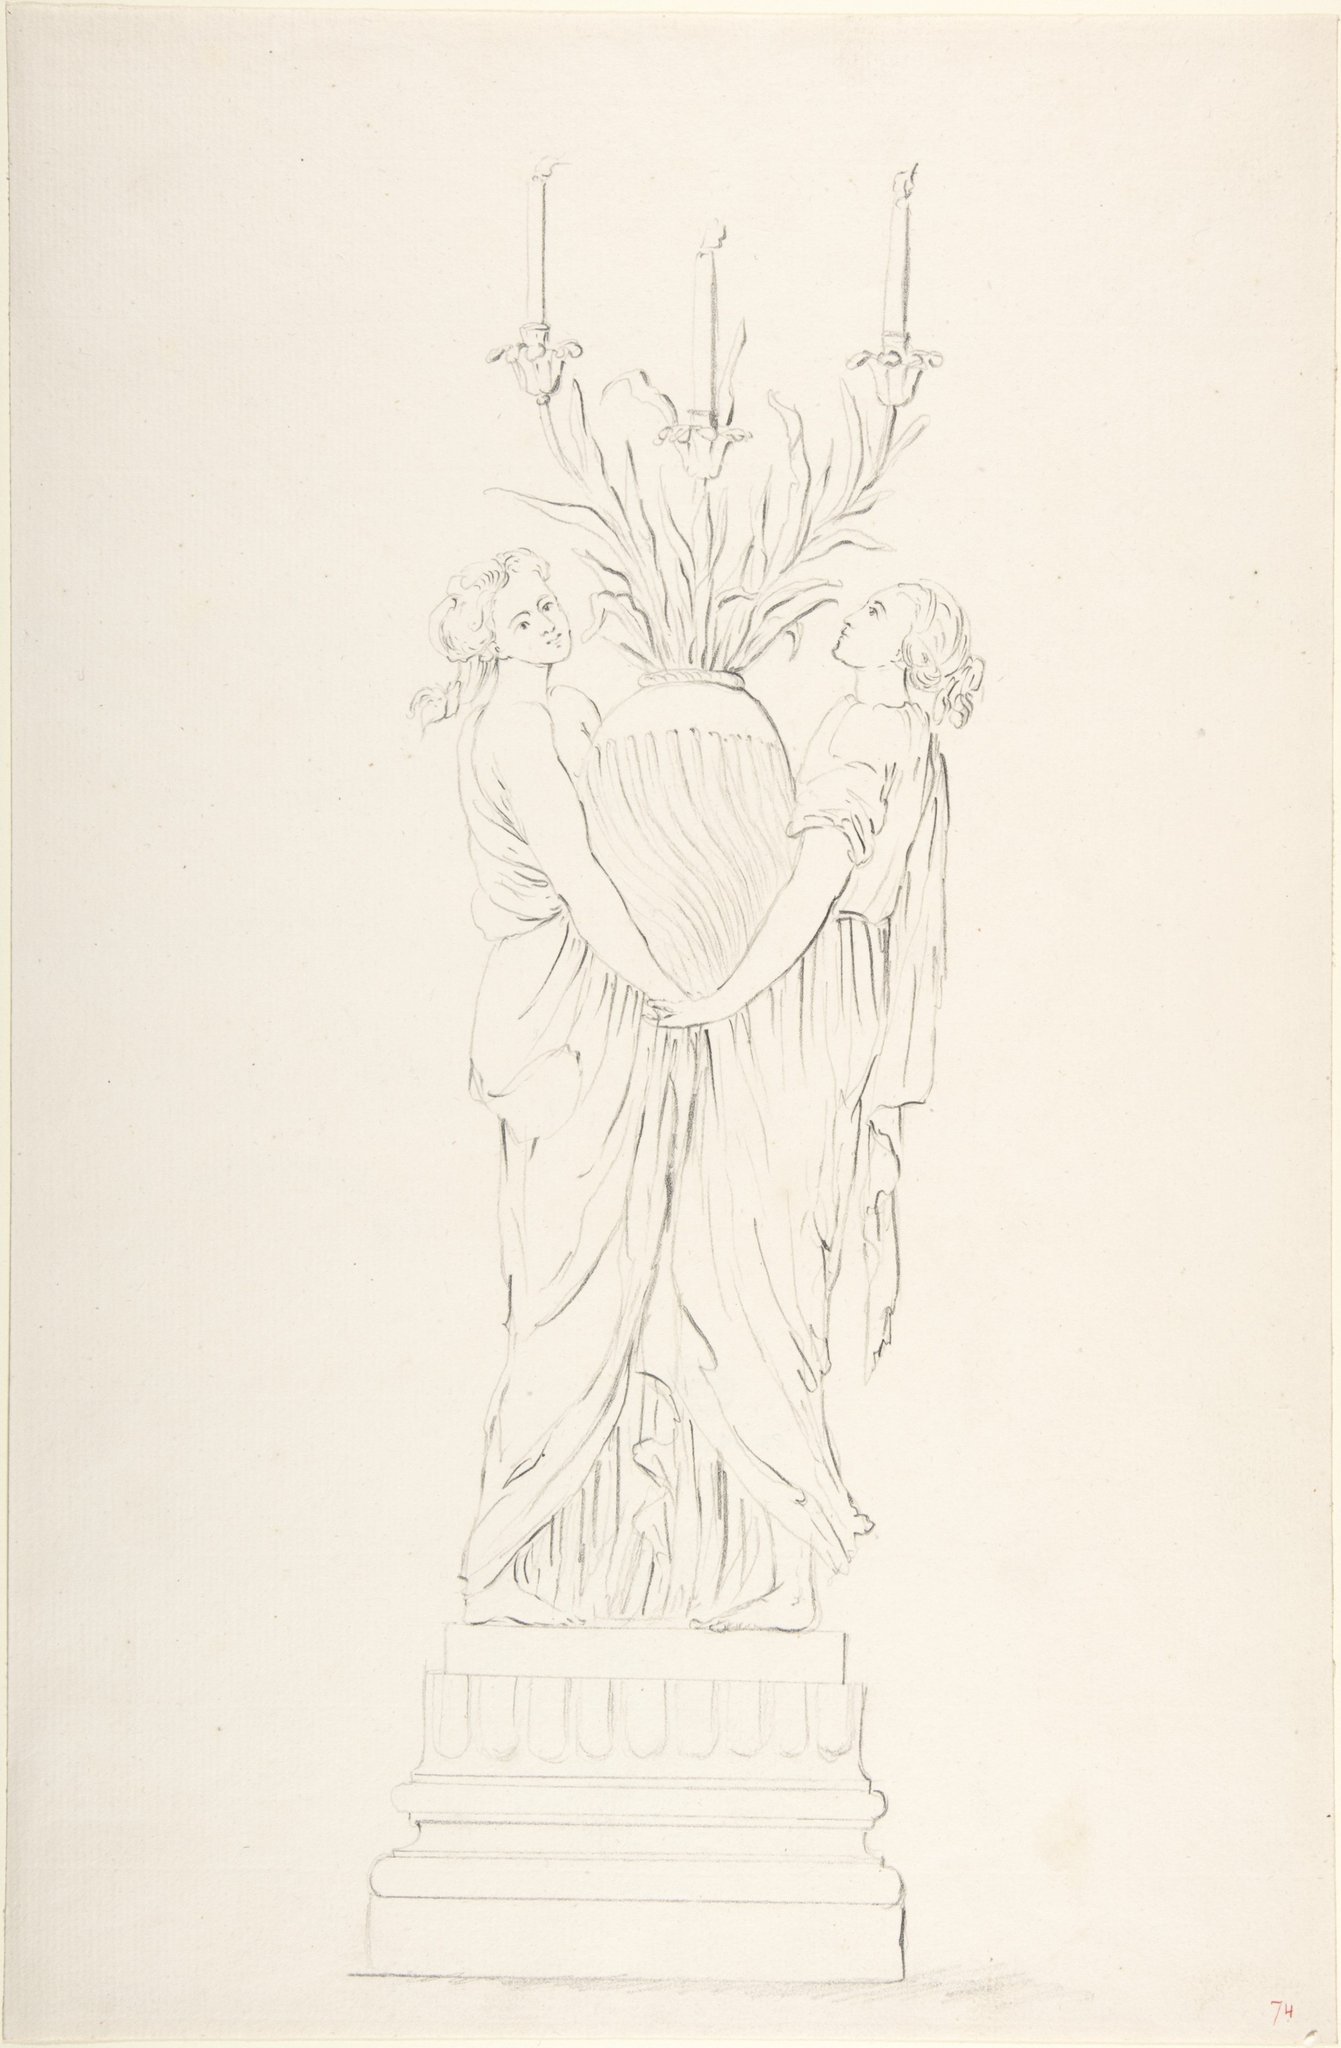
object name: drawing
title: Design for a Candelabra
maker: anonymous, french, 18th century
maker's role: artist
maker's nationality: french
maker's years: 1700-1800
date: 1770-1790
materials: graphite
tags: candelabra